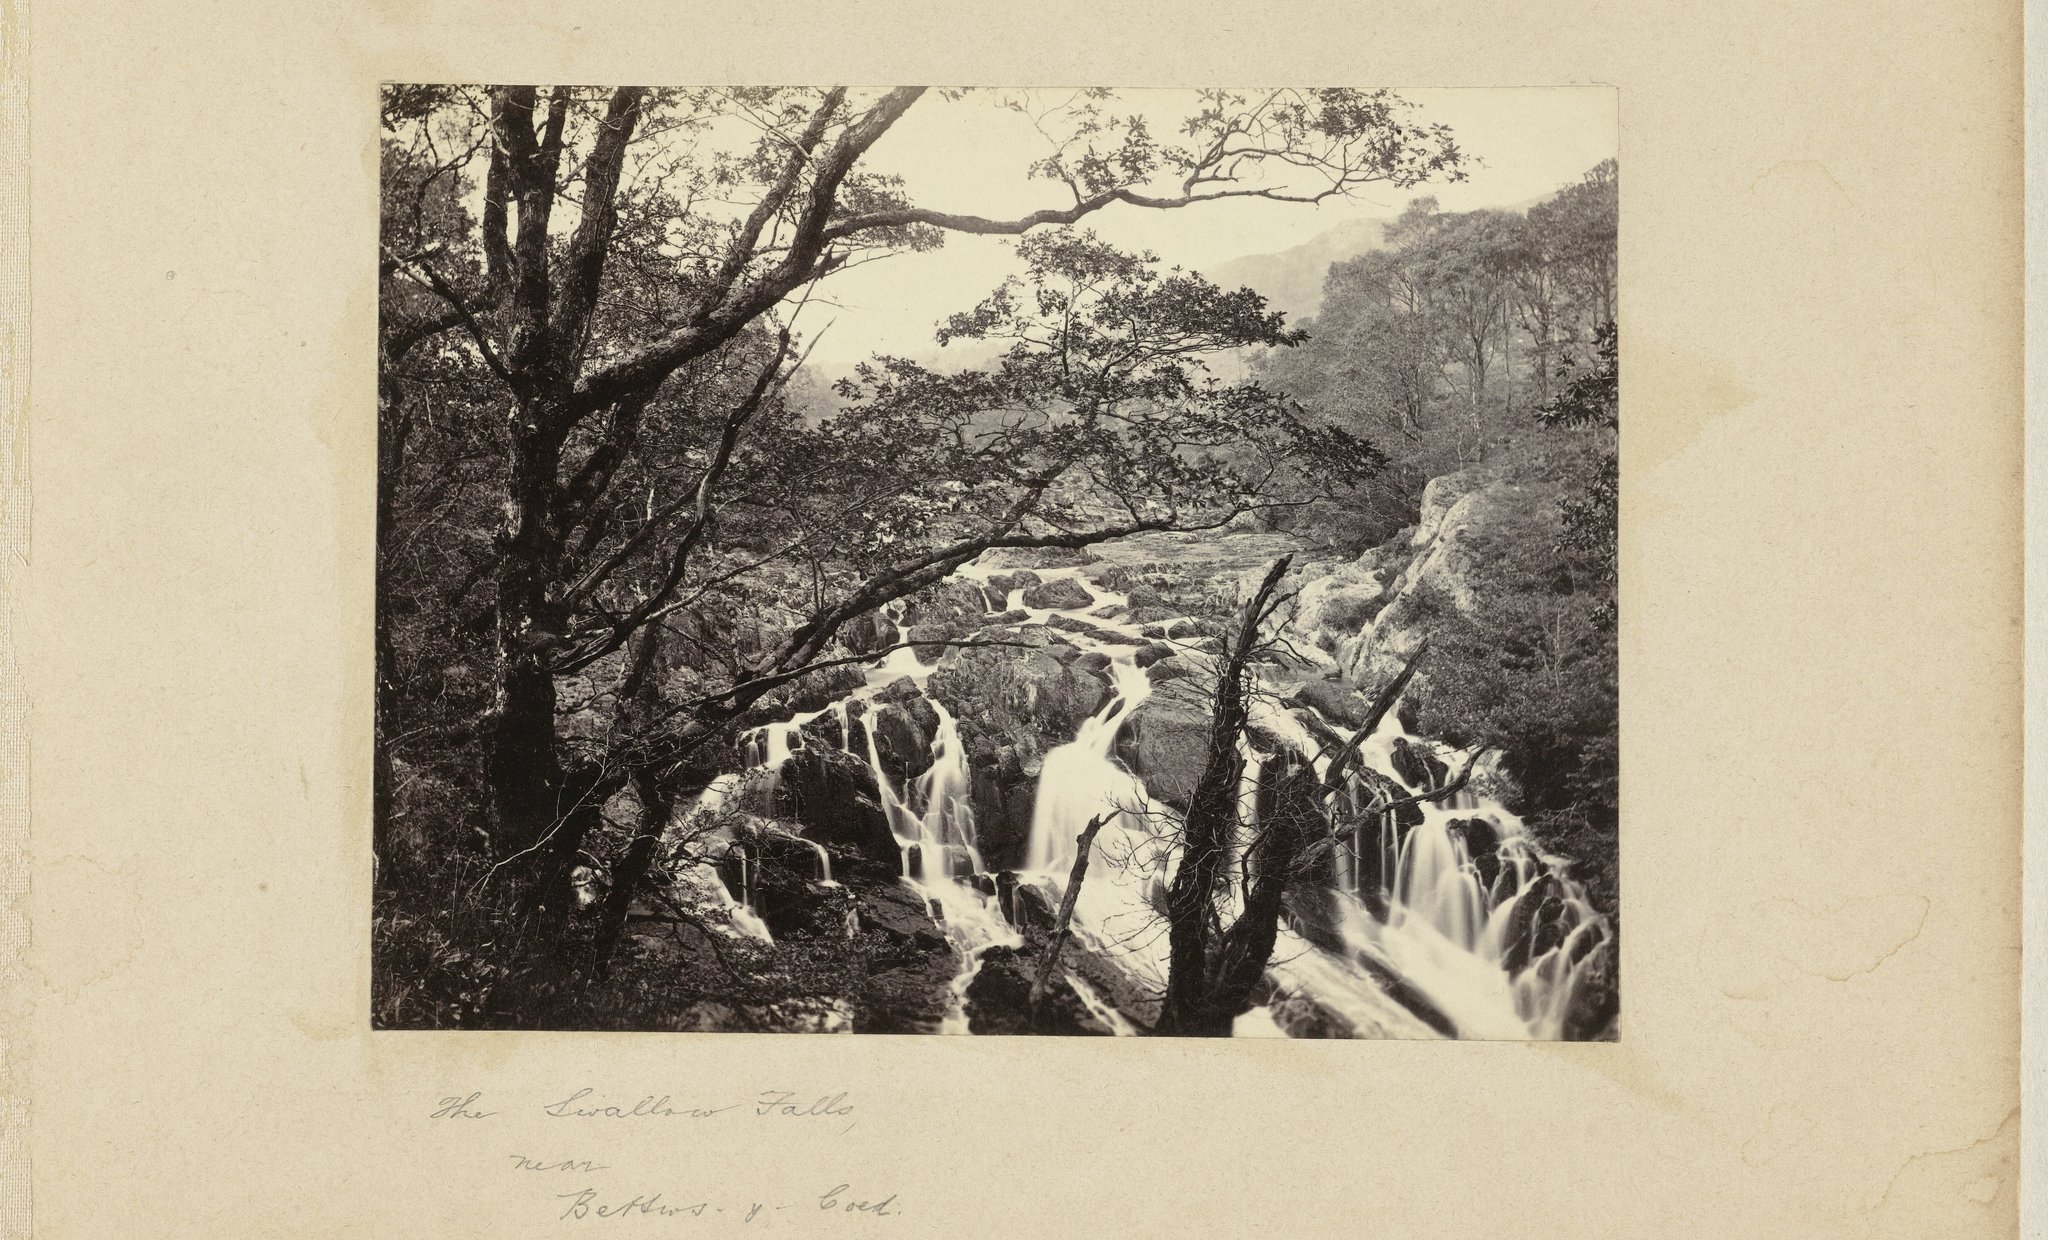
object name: photograph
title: The Swallow Falls, near Bettws-y-Coed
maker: Anonymous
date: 1855-1900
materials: cardboard, paper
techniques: albumen print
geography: bettws-y-coed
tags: waterfall